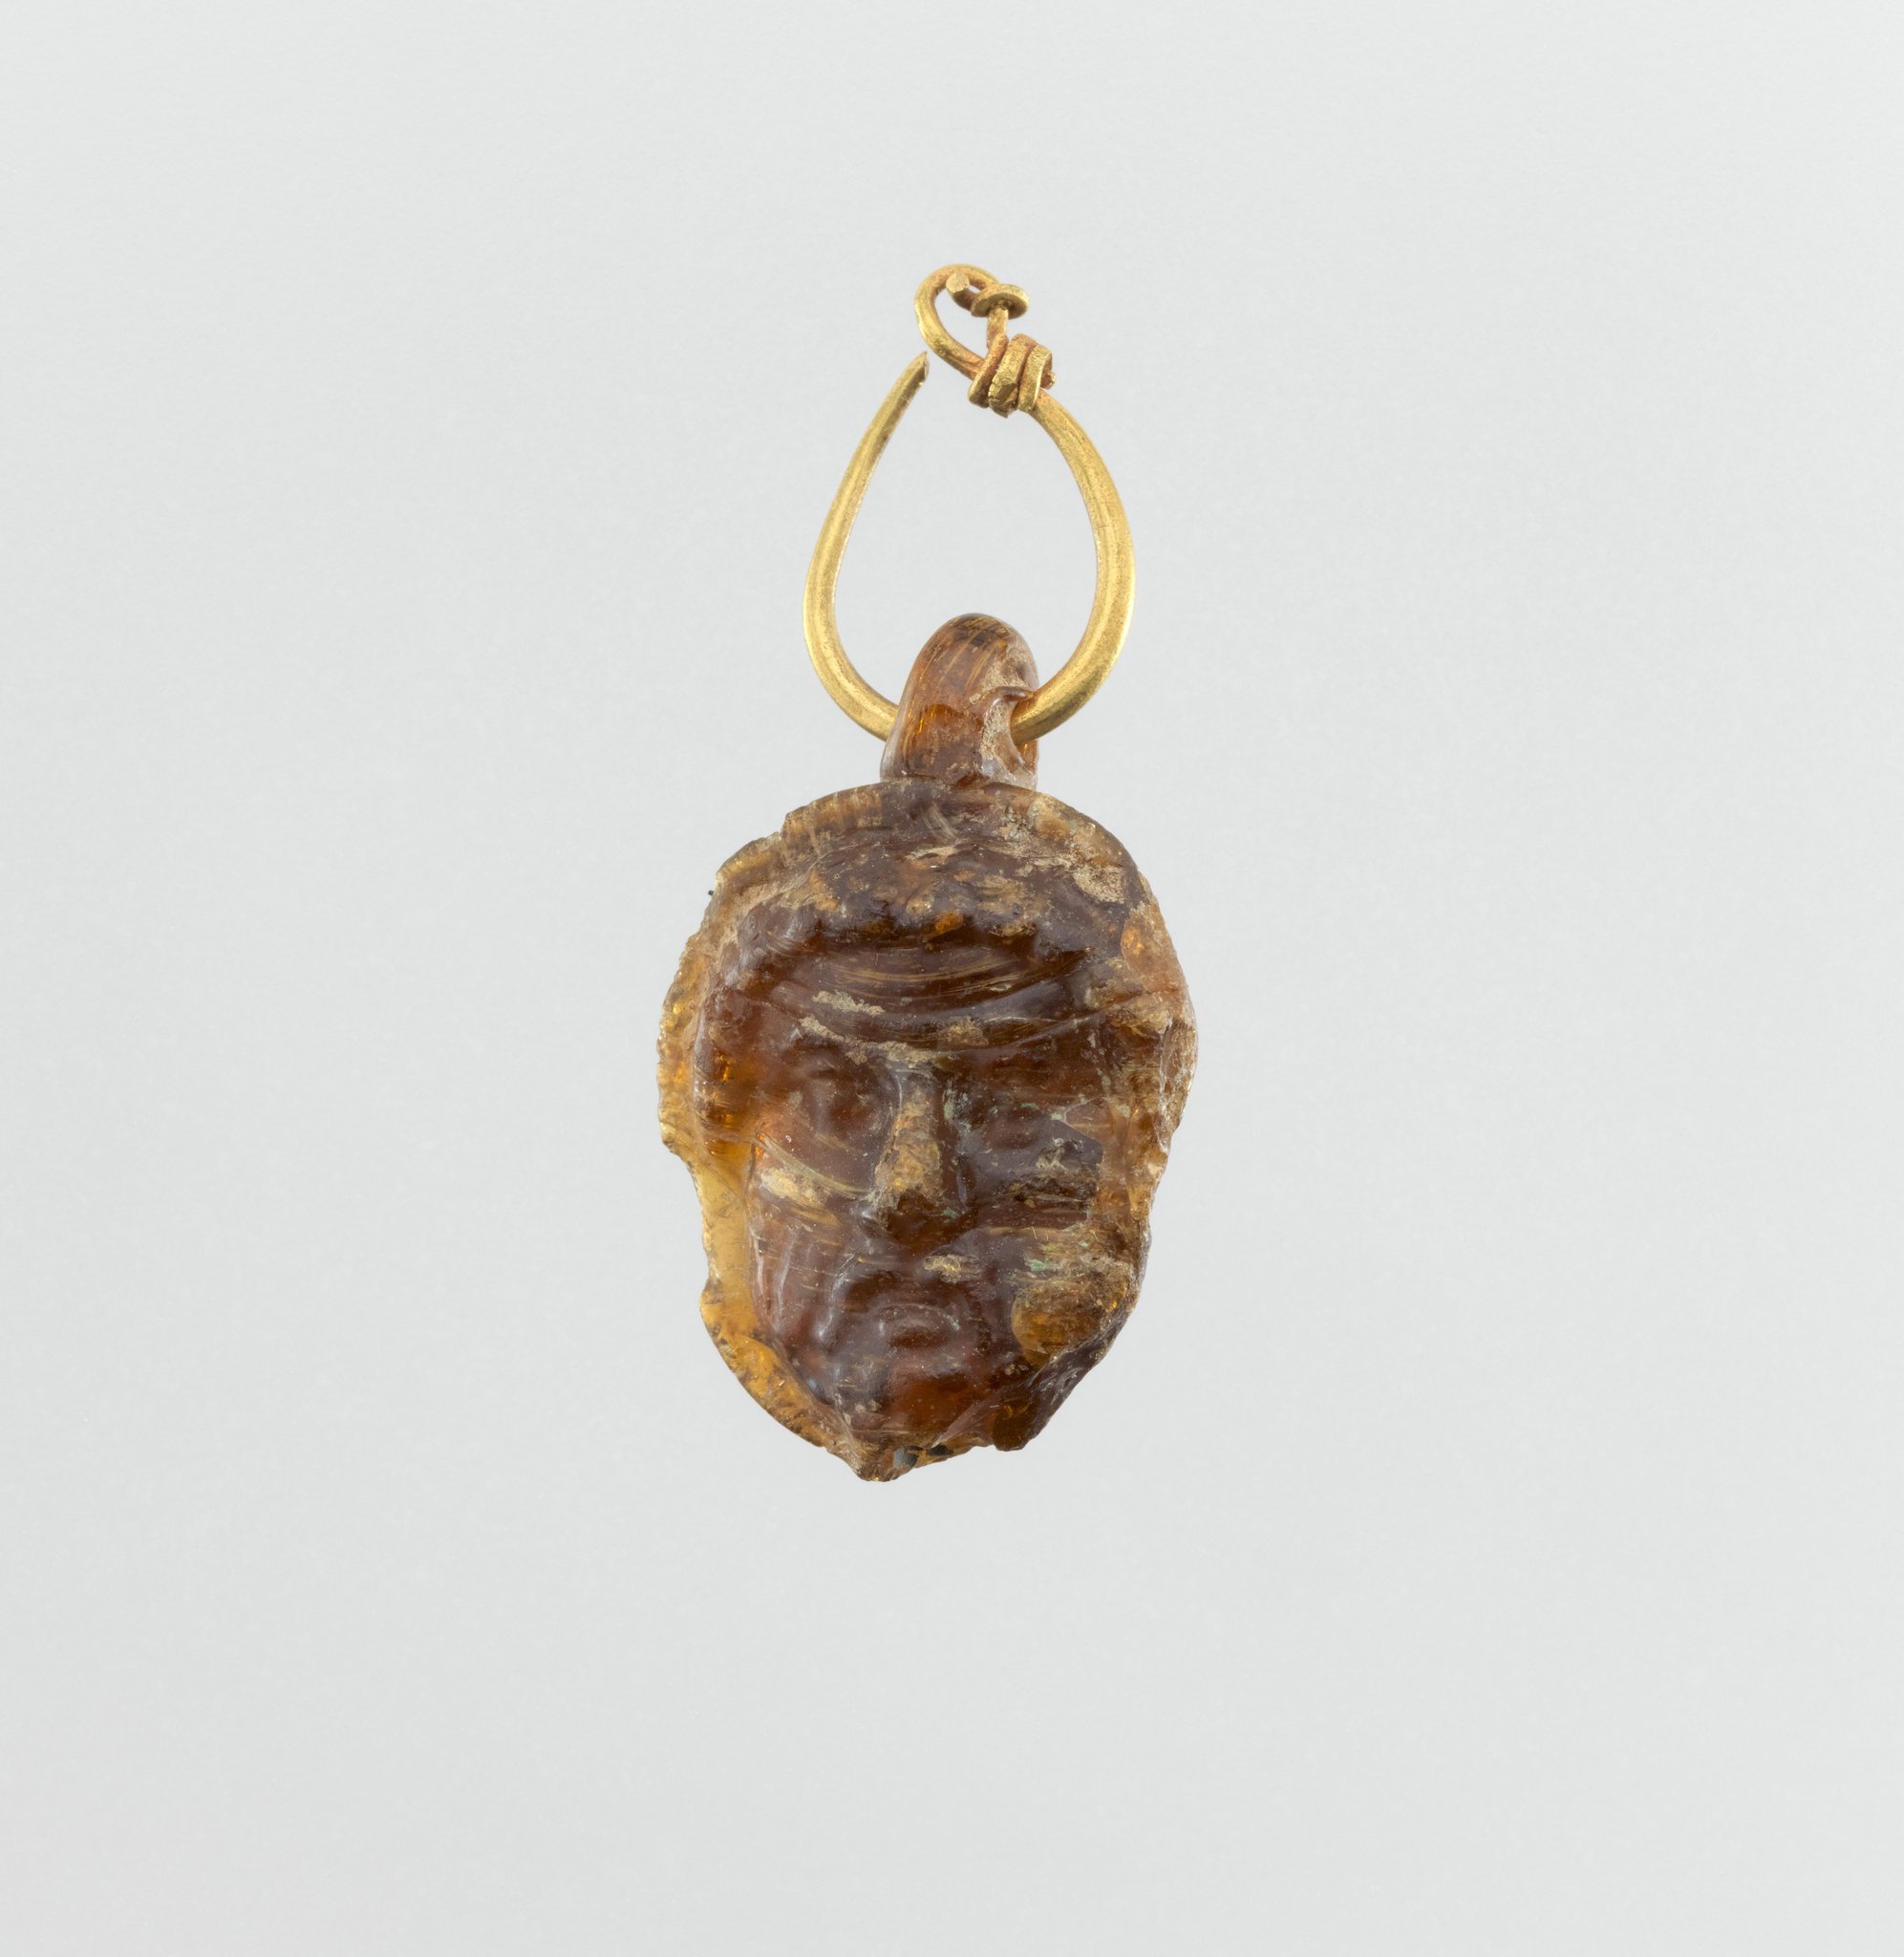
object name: earring with pendant of two male head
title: Glass double-headed pendant with gold hoop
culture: punic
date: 334-201 BCE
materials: glass, gold